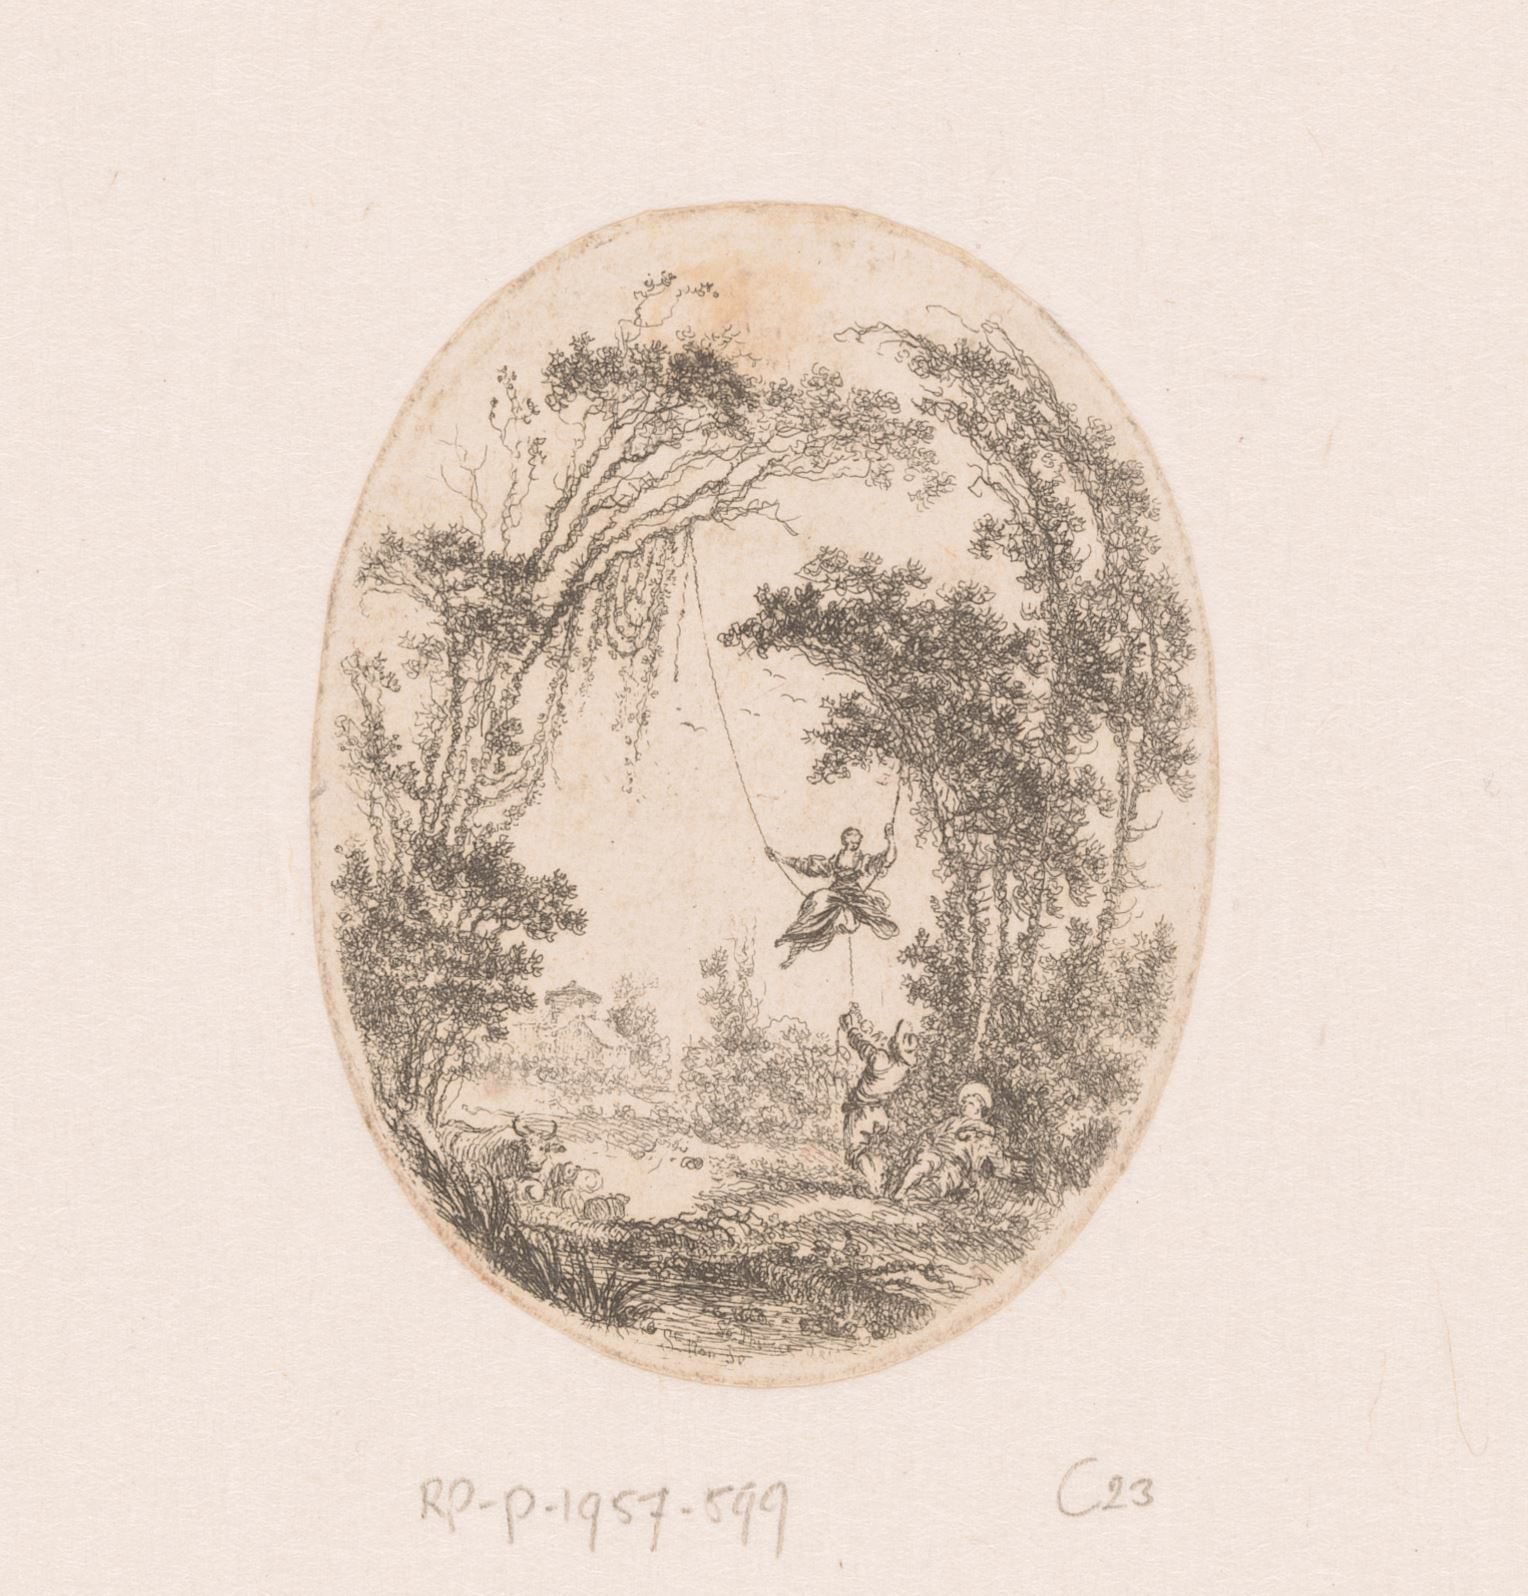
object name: print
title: Boslandschap met vrouw op schommel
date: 1755-1760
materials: paper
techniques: etching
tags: herding, herdsman, herdswoman, shepherd, shepherdess, cowherd, etc., forest, wood, swing, pastorals, arcadian scenes